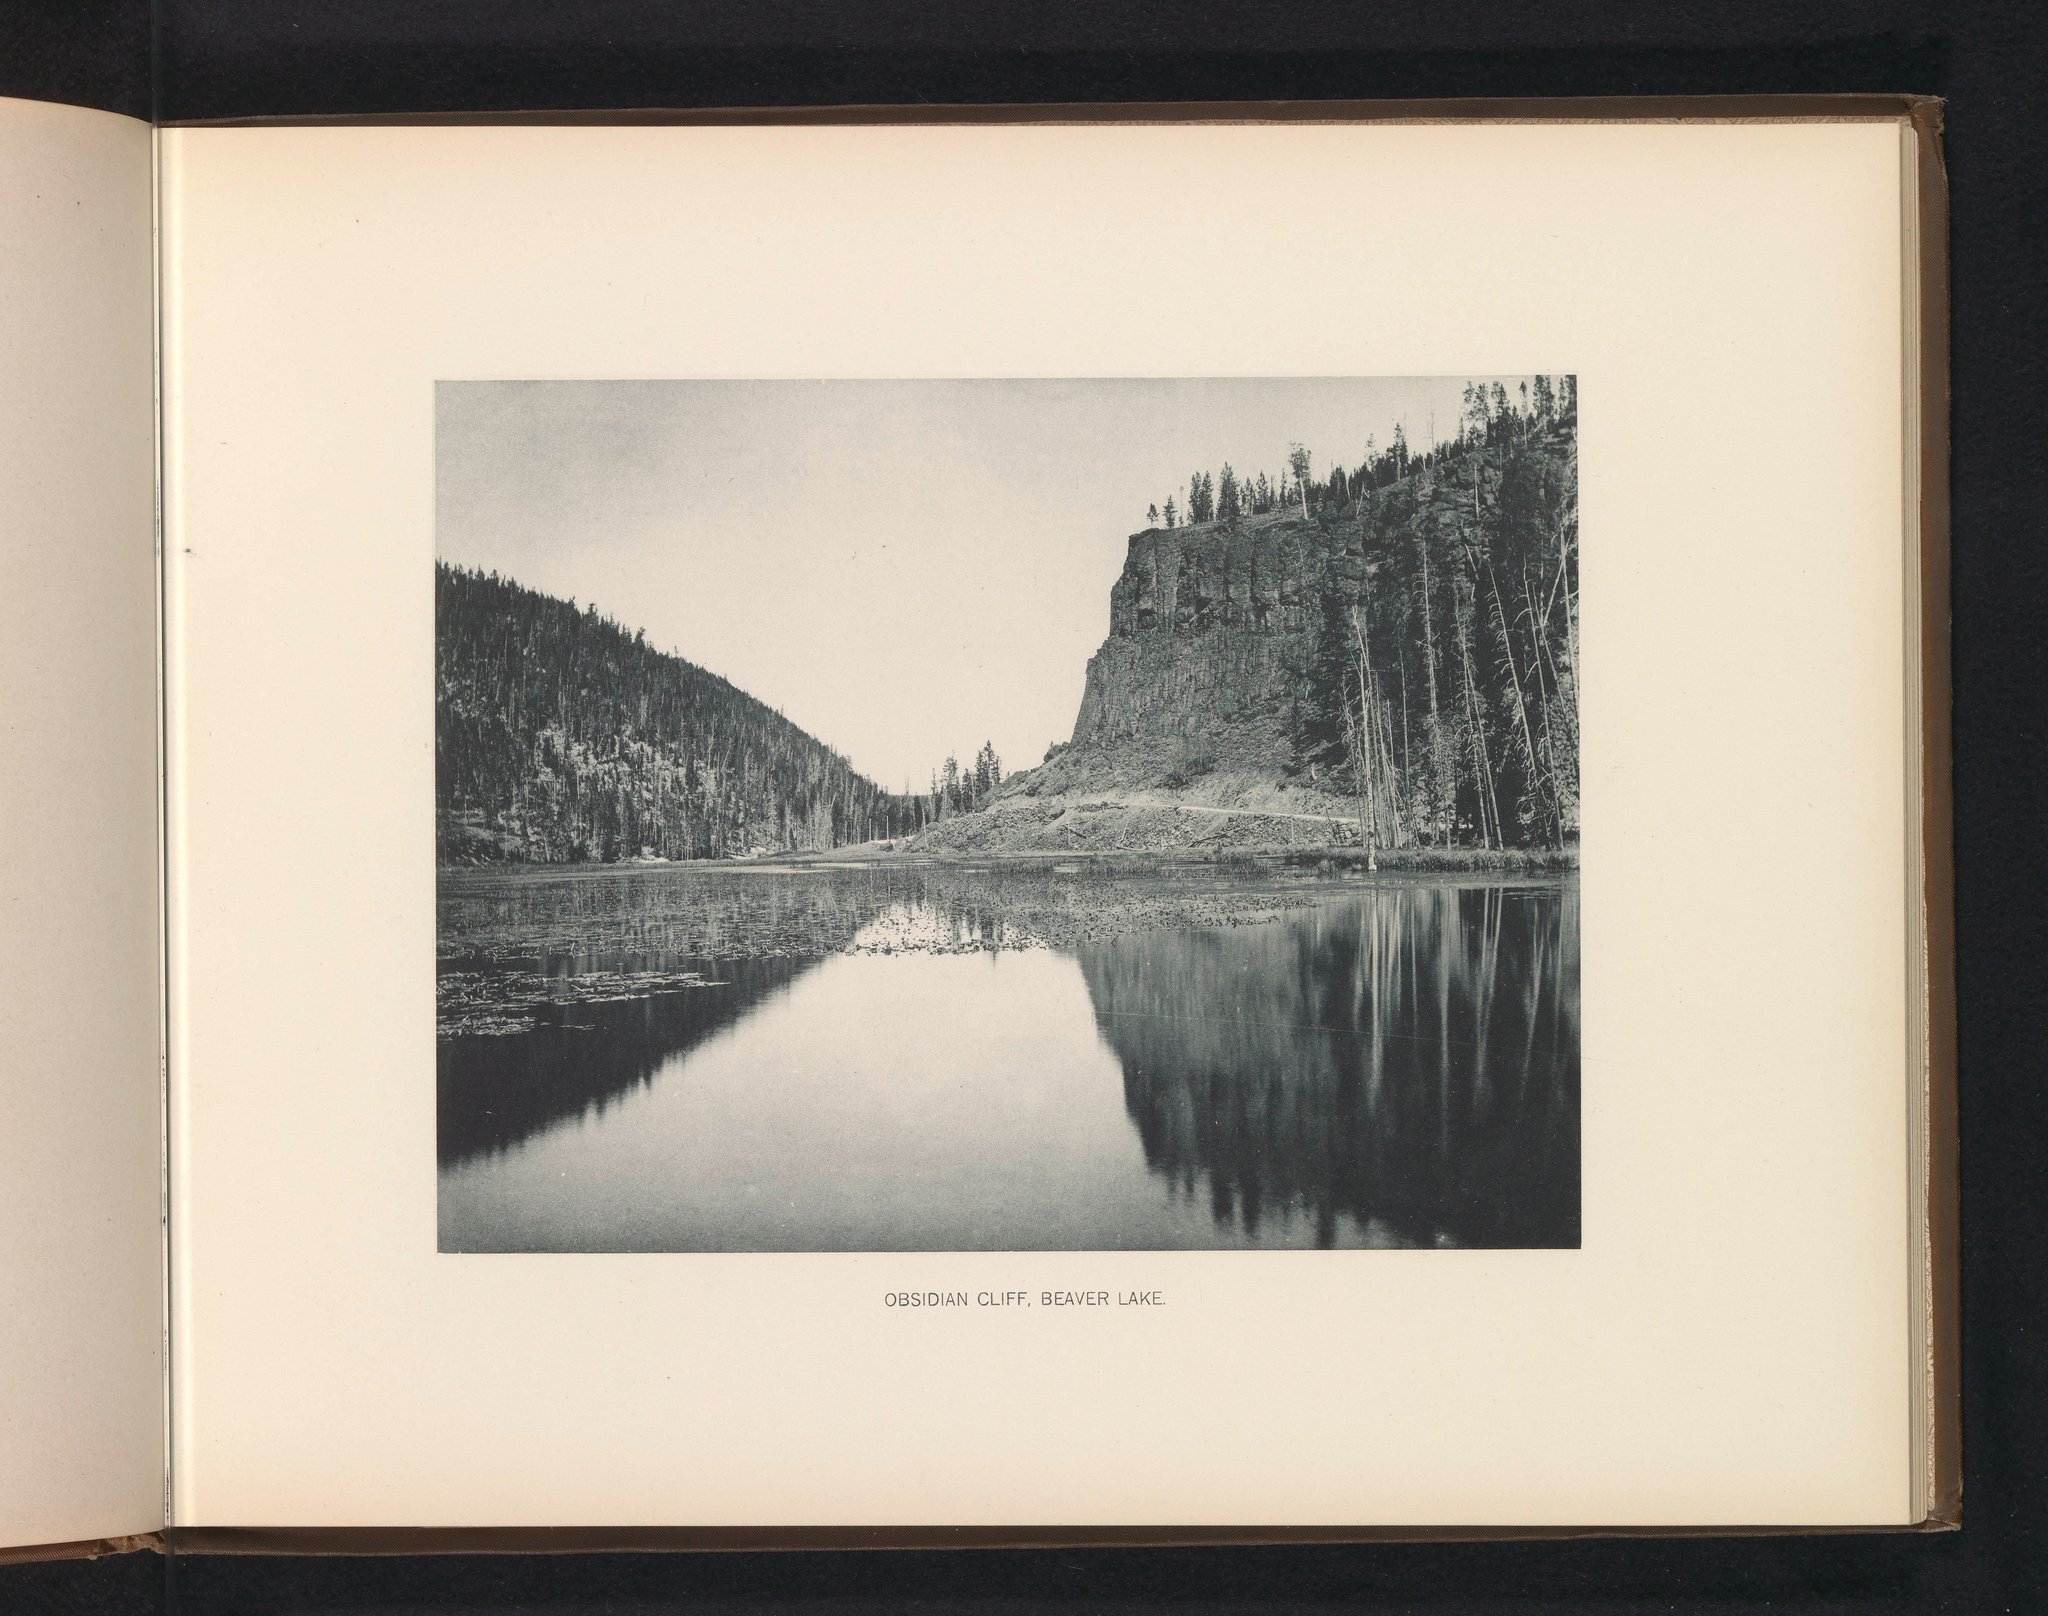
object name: page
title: Obsidian cliff, Beaver Lake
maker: frank jay haynes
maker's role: fotograaf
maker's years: 1853-1921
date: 1886-1891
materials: paper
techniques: photograph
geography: new york city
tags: ravine, chasm, abyss, canyon